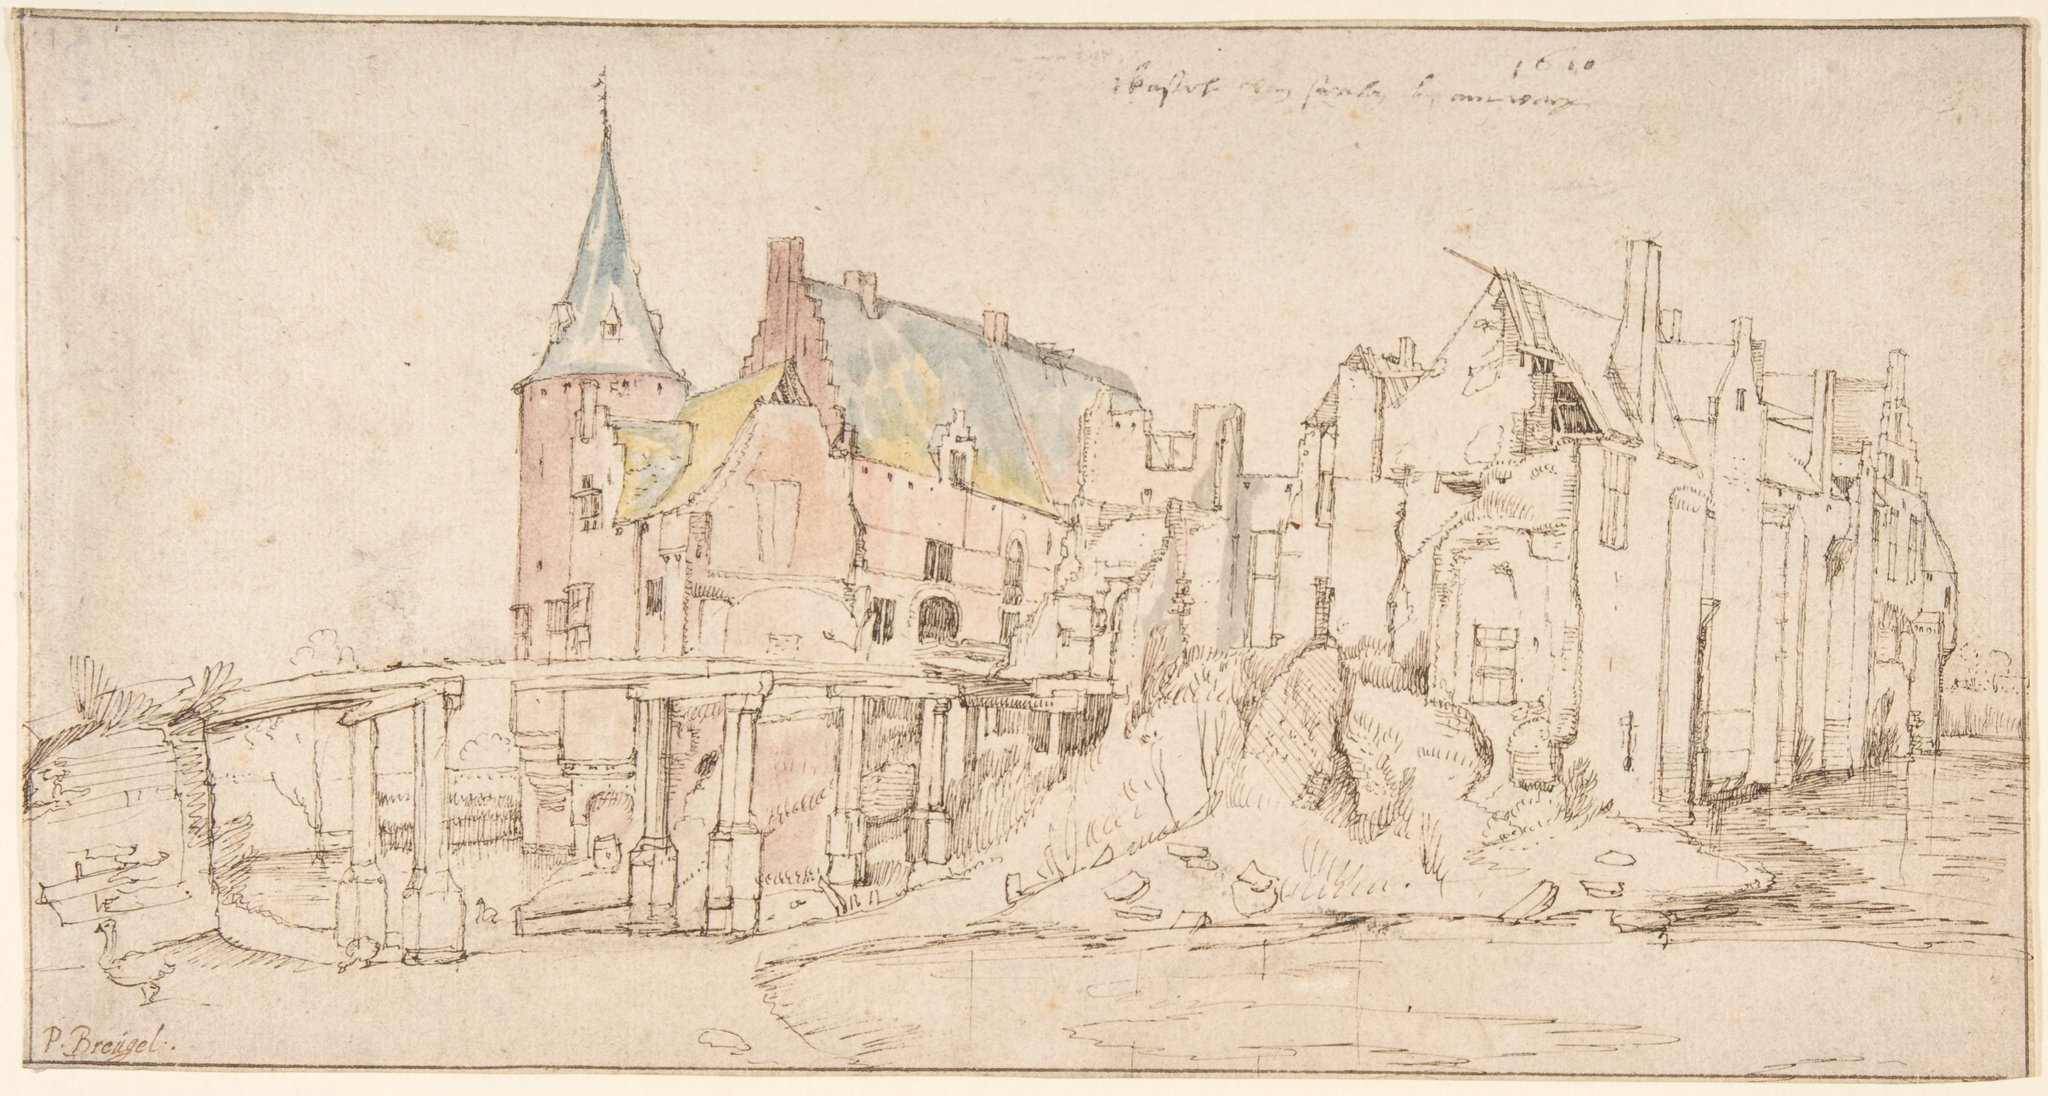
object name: drawing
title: The Ruins of Castle Merxem, near Antwerp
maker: jan brueghel the elder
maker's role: artist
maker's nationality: netherlandish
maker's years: 1568-1625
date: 1610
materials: ink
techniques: pen, wash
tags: castles,ruins